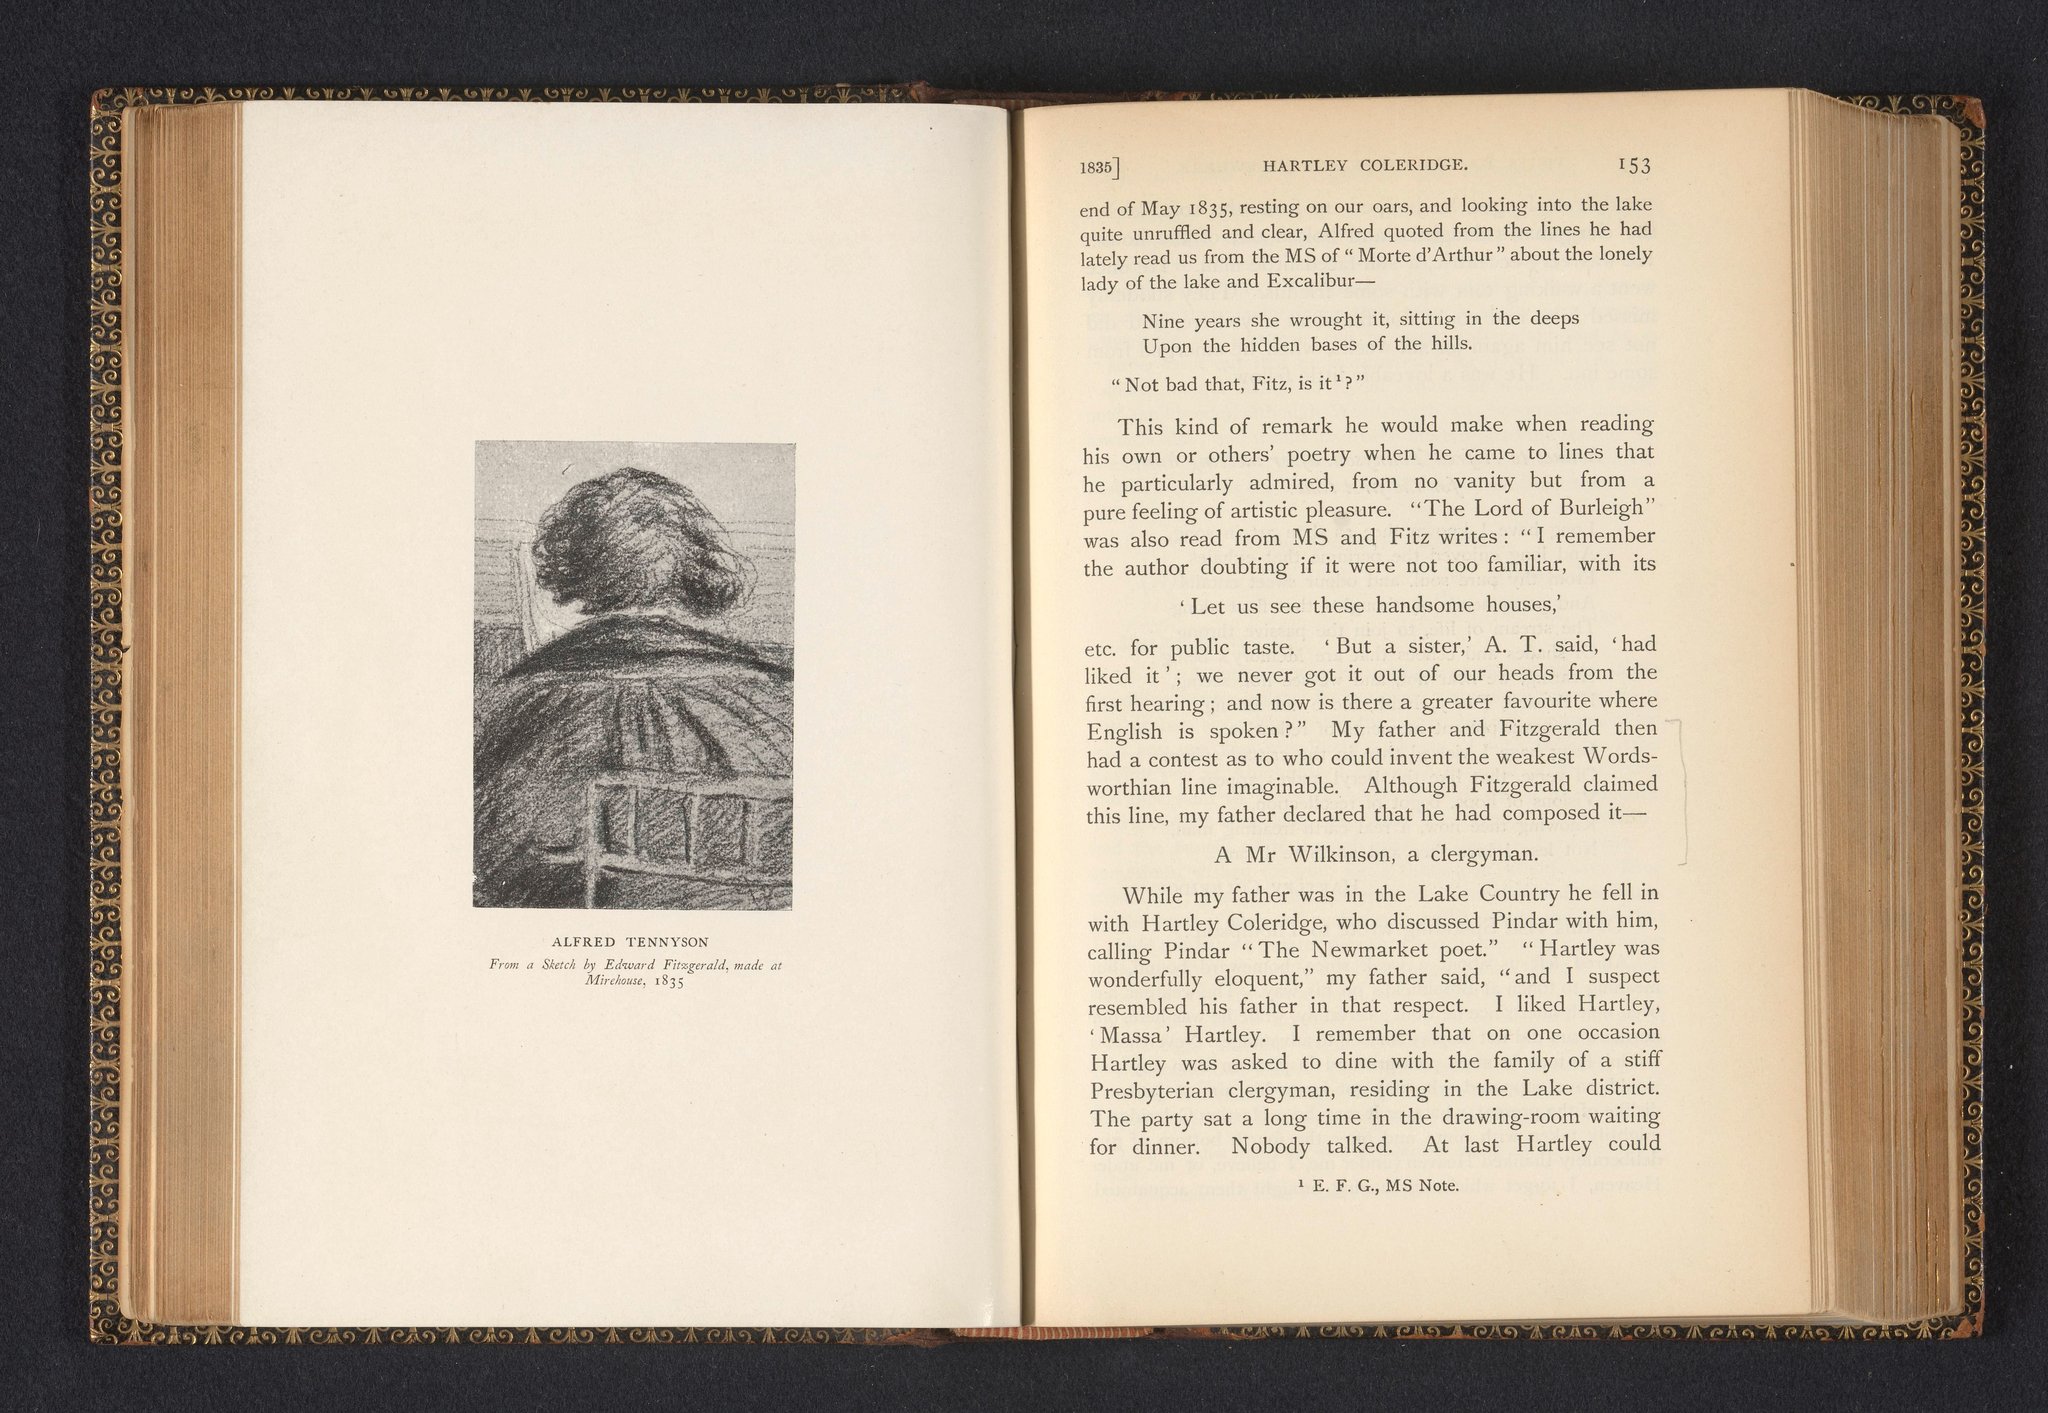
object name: reproduction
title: Alfred Tennyson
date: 1887-1897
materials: paper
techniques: autotype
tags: alfred tennyson, portrait of a writer